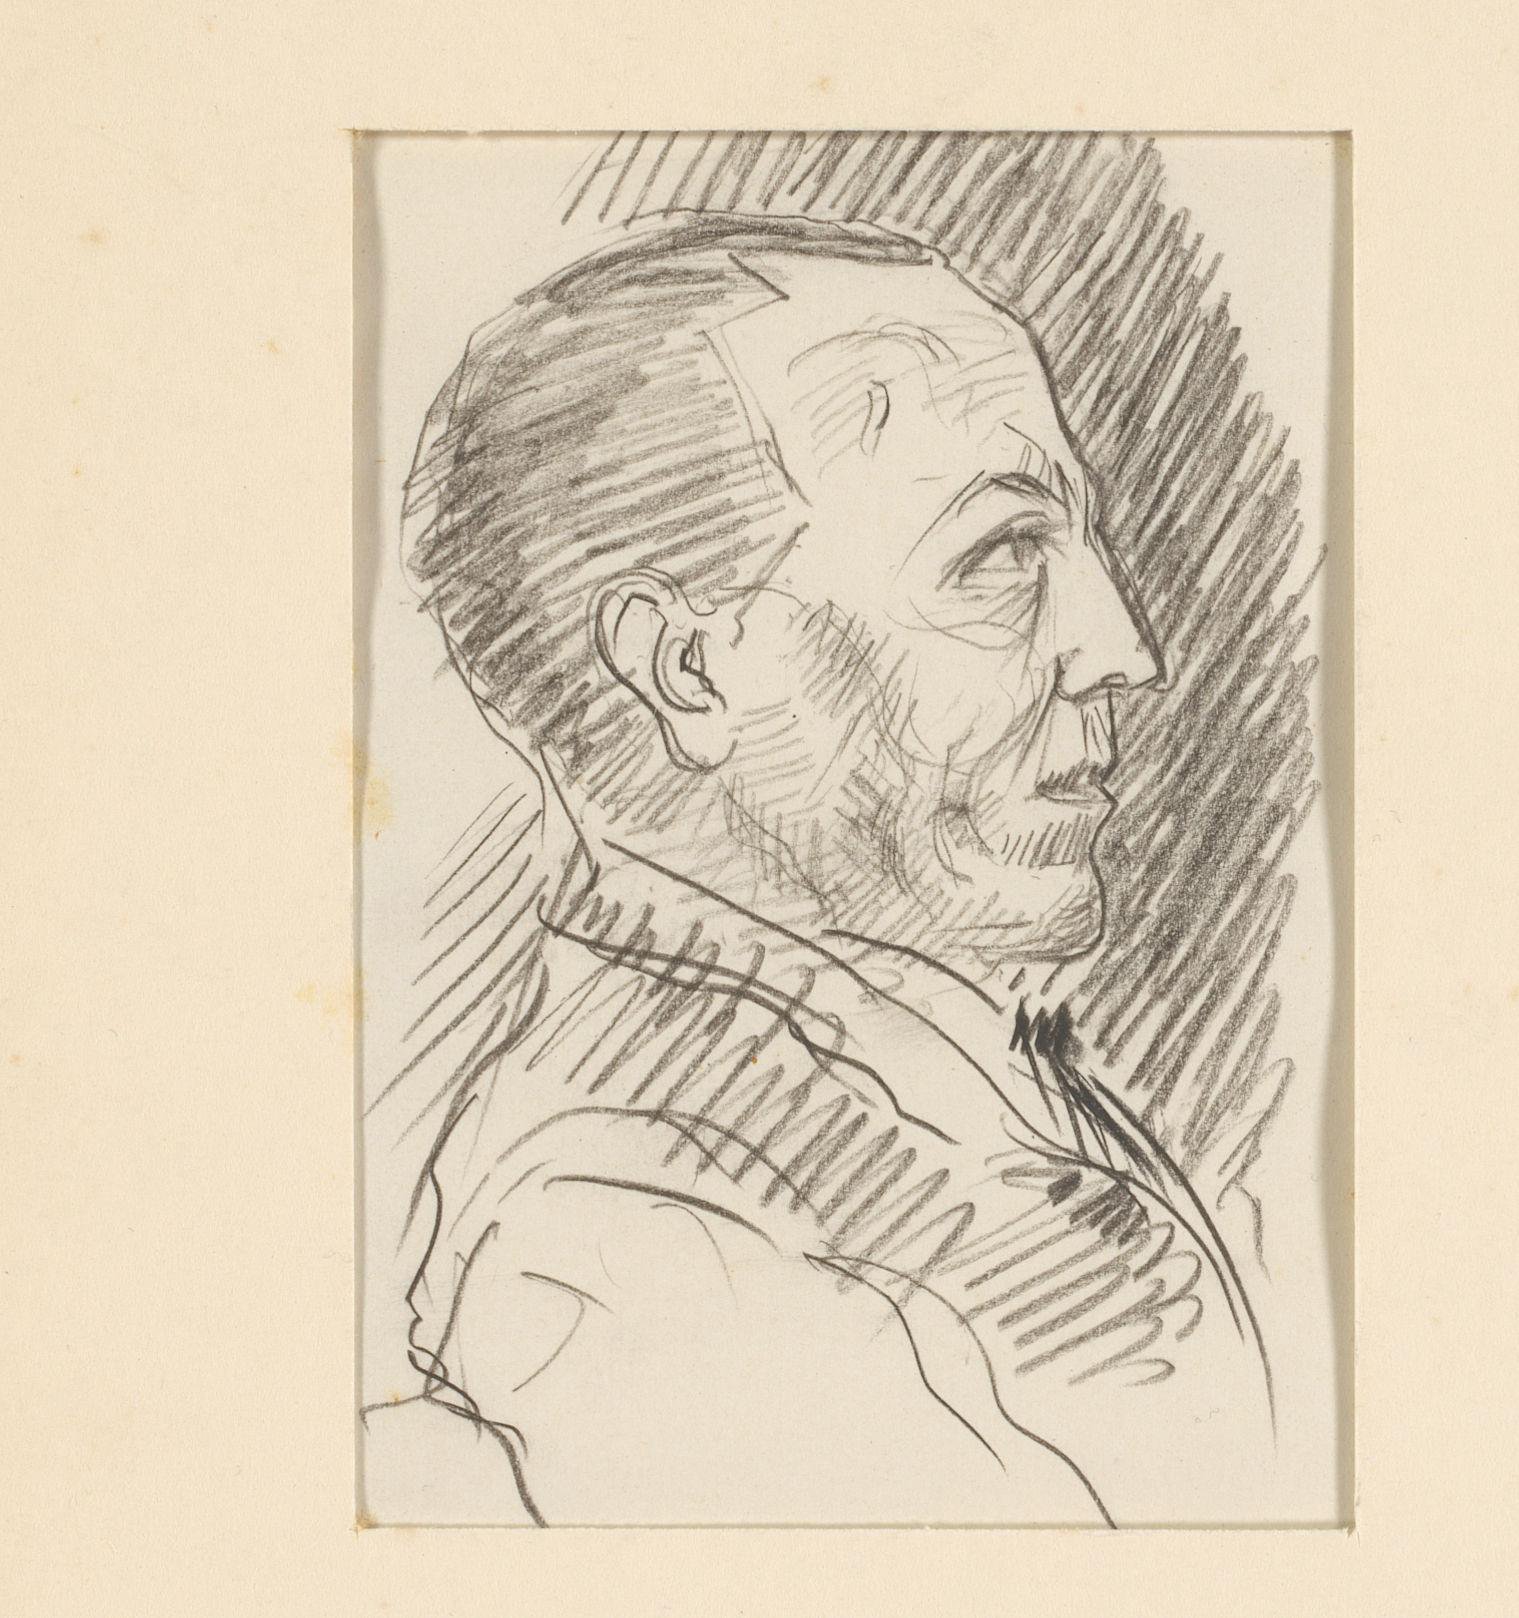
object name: drawing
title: Portret van een onbekende man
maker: Anonymous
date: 1920-1986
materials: chalk, paper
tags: historical persons not known by name